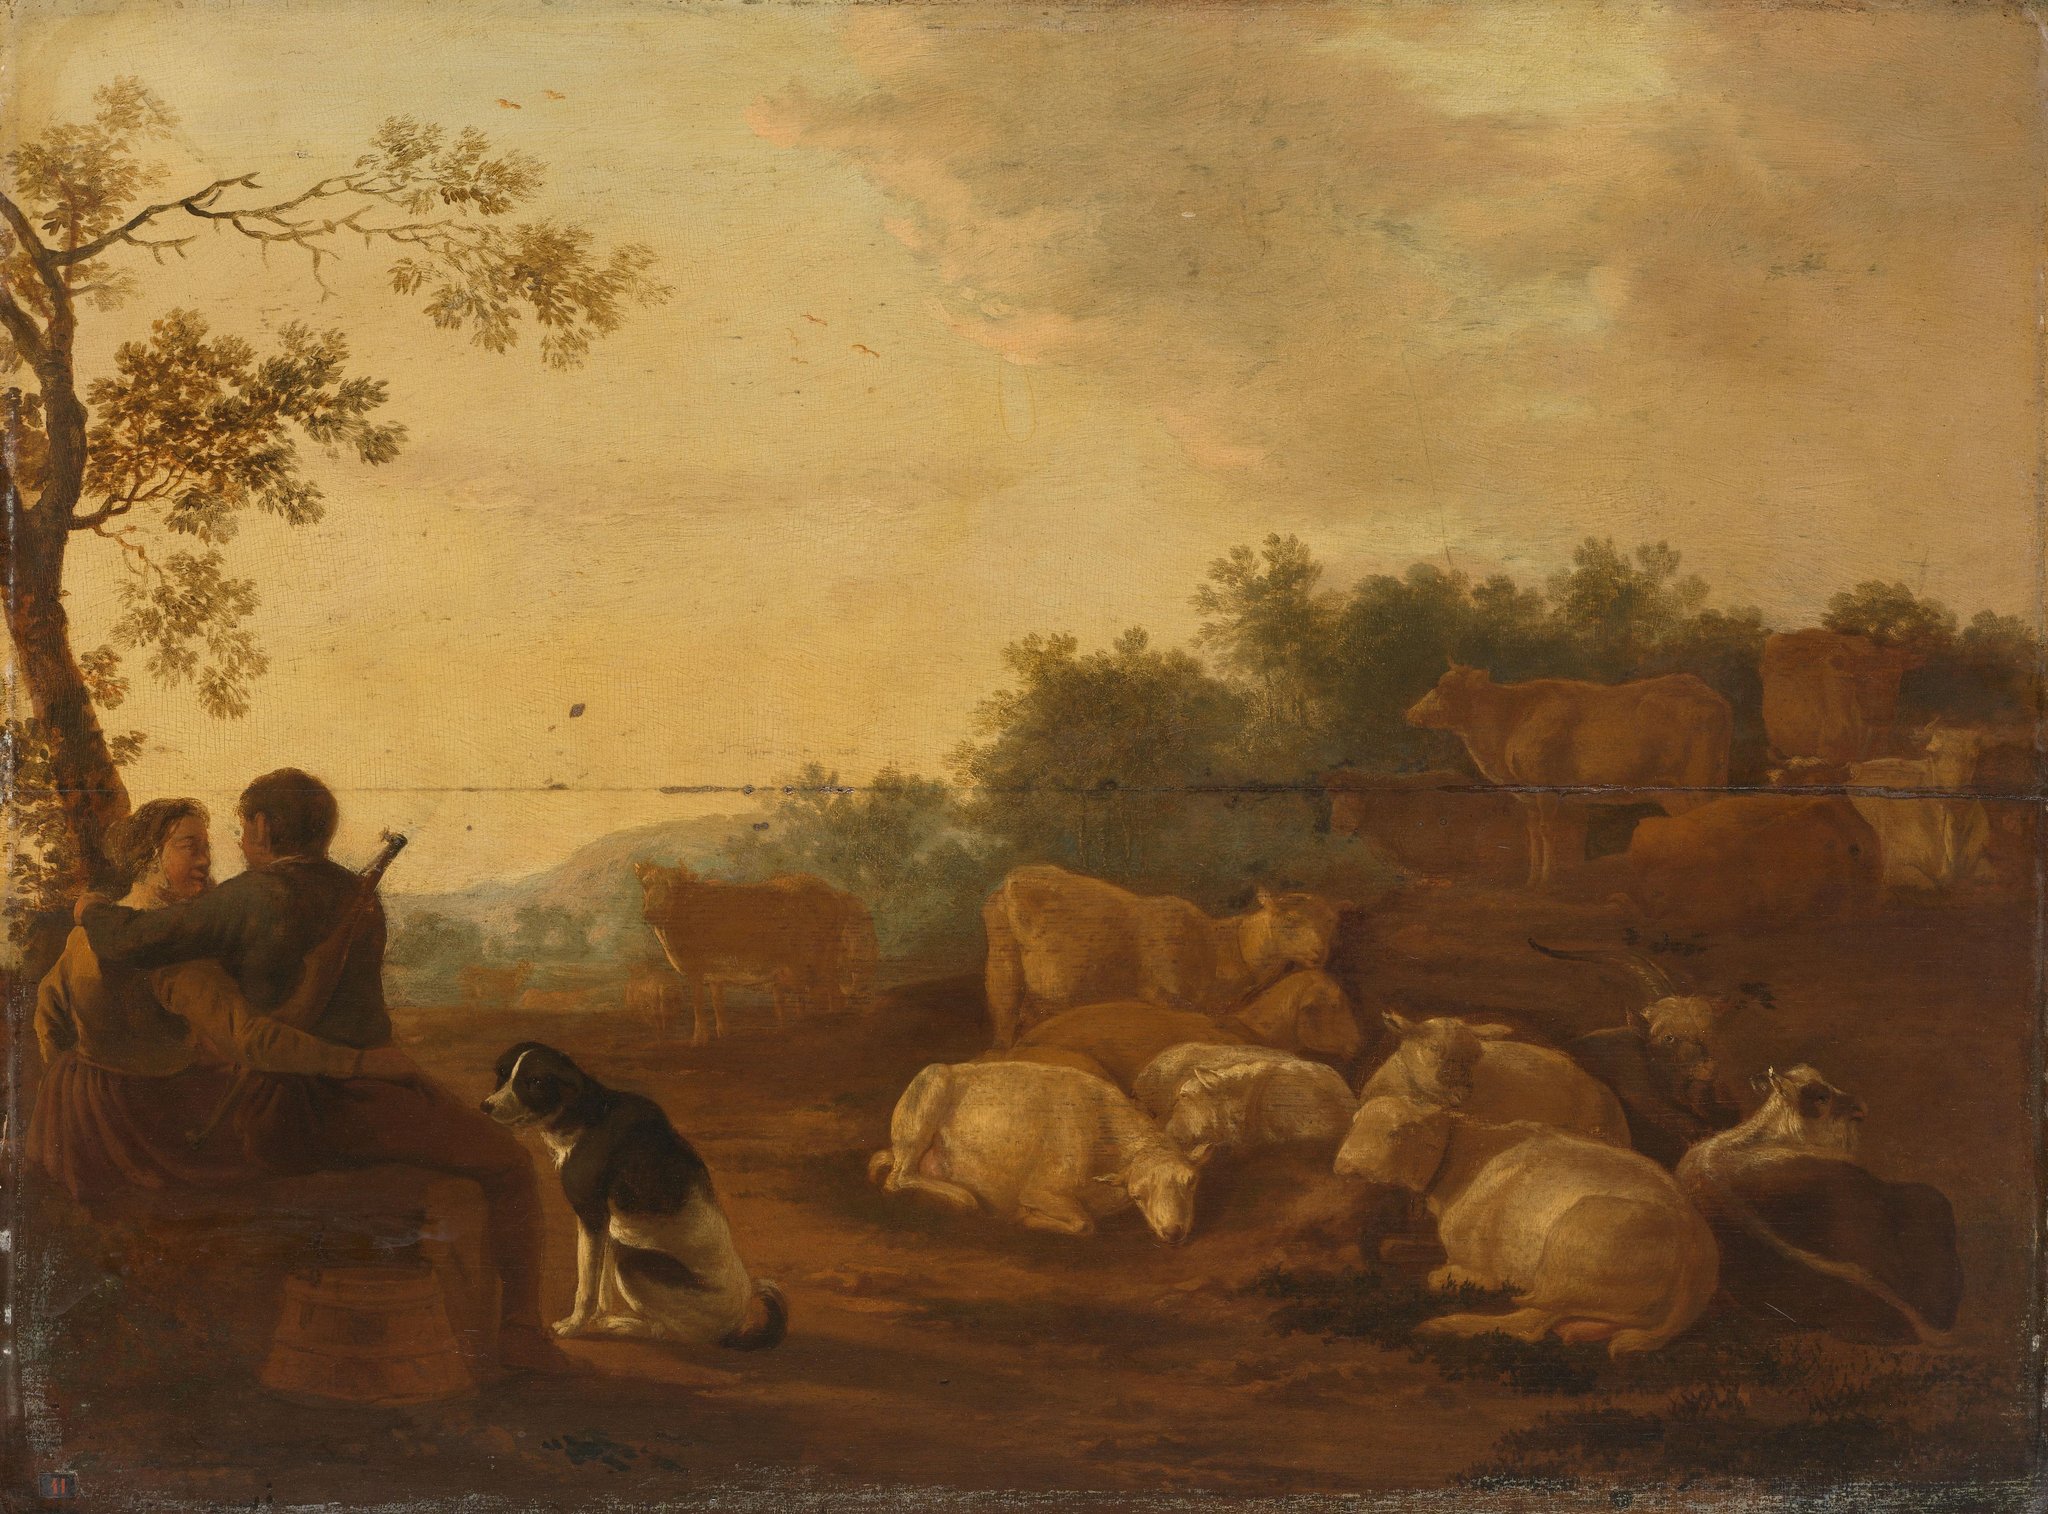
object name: painting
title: Landscape with sheperd, sheperdess and cattle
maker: willem ossenbeeck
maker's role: painter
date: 1632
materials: oil, panel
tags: herding, herdsman, herdswoman, shepherd, shepherdess, cowherd, etc., pastorals, arcadian scenes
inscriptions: signature: ‘Ossenbeeck’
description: Landschap met herderspaar en vee. Links zitten een herder en herderin met de armen om elkaar, op de grond een hond. Rechts een kudde koeien.